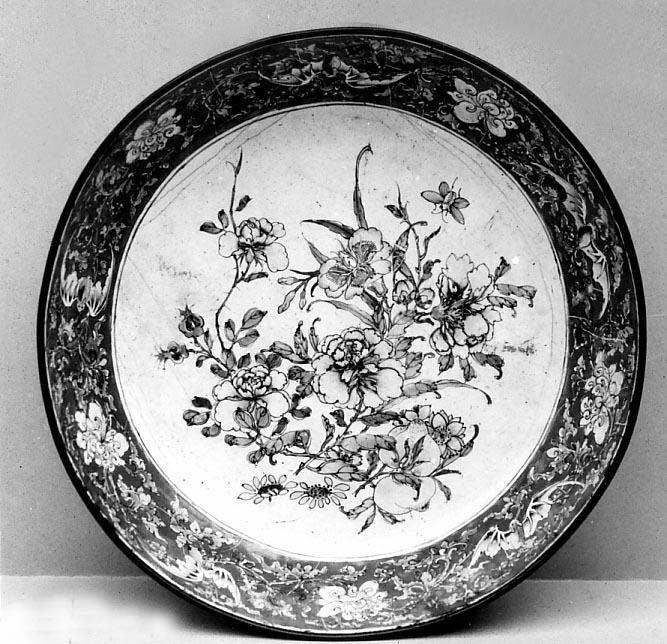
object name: dish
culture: chinese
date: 1736-1795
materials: enamel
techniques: painting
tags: insects,flowers